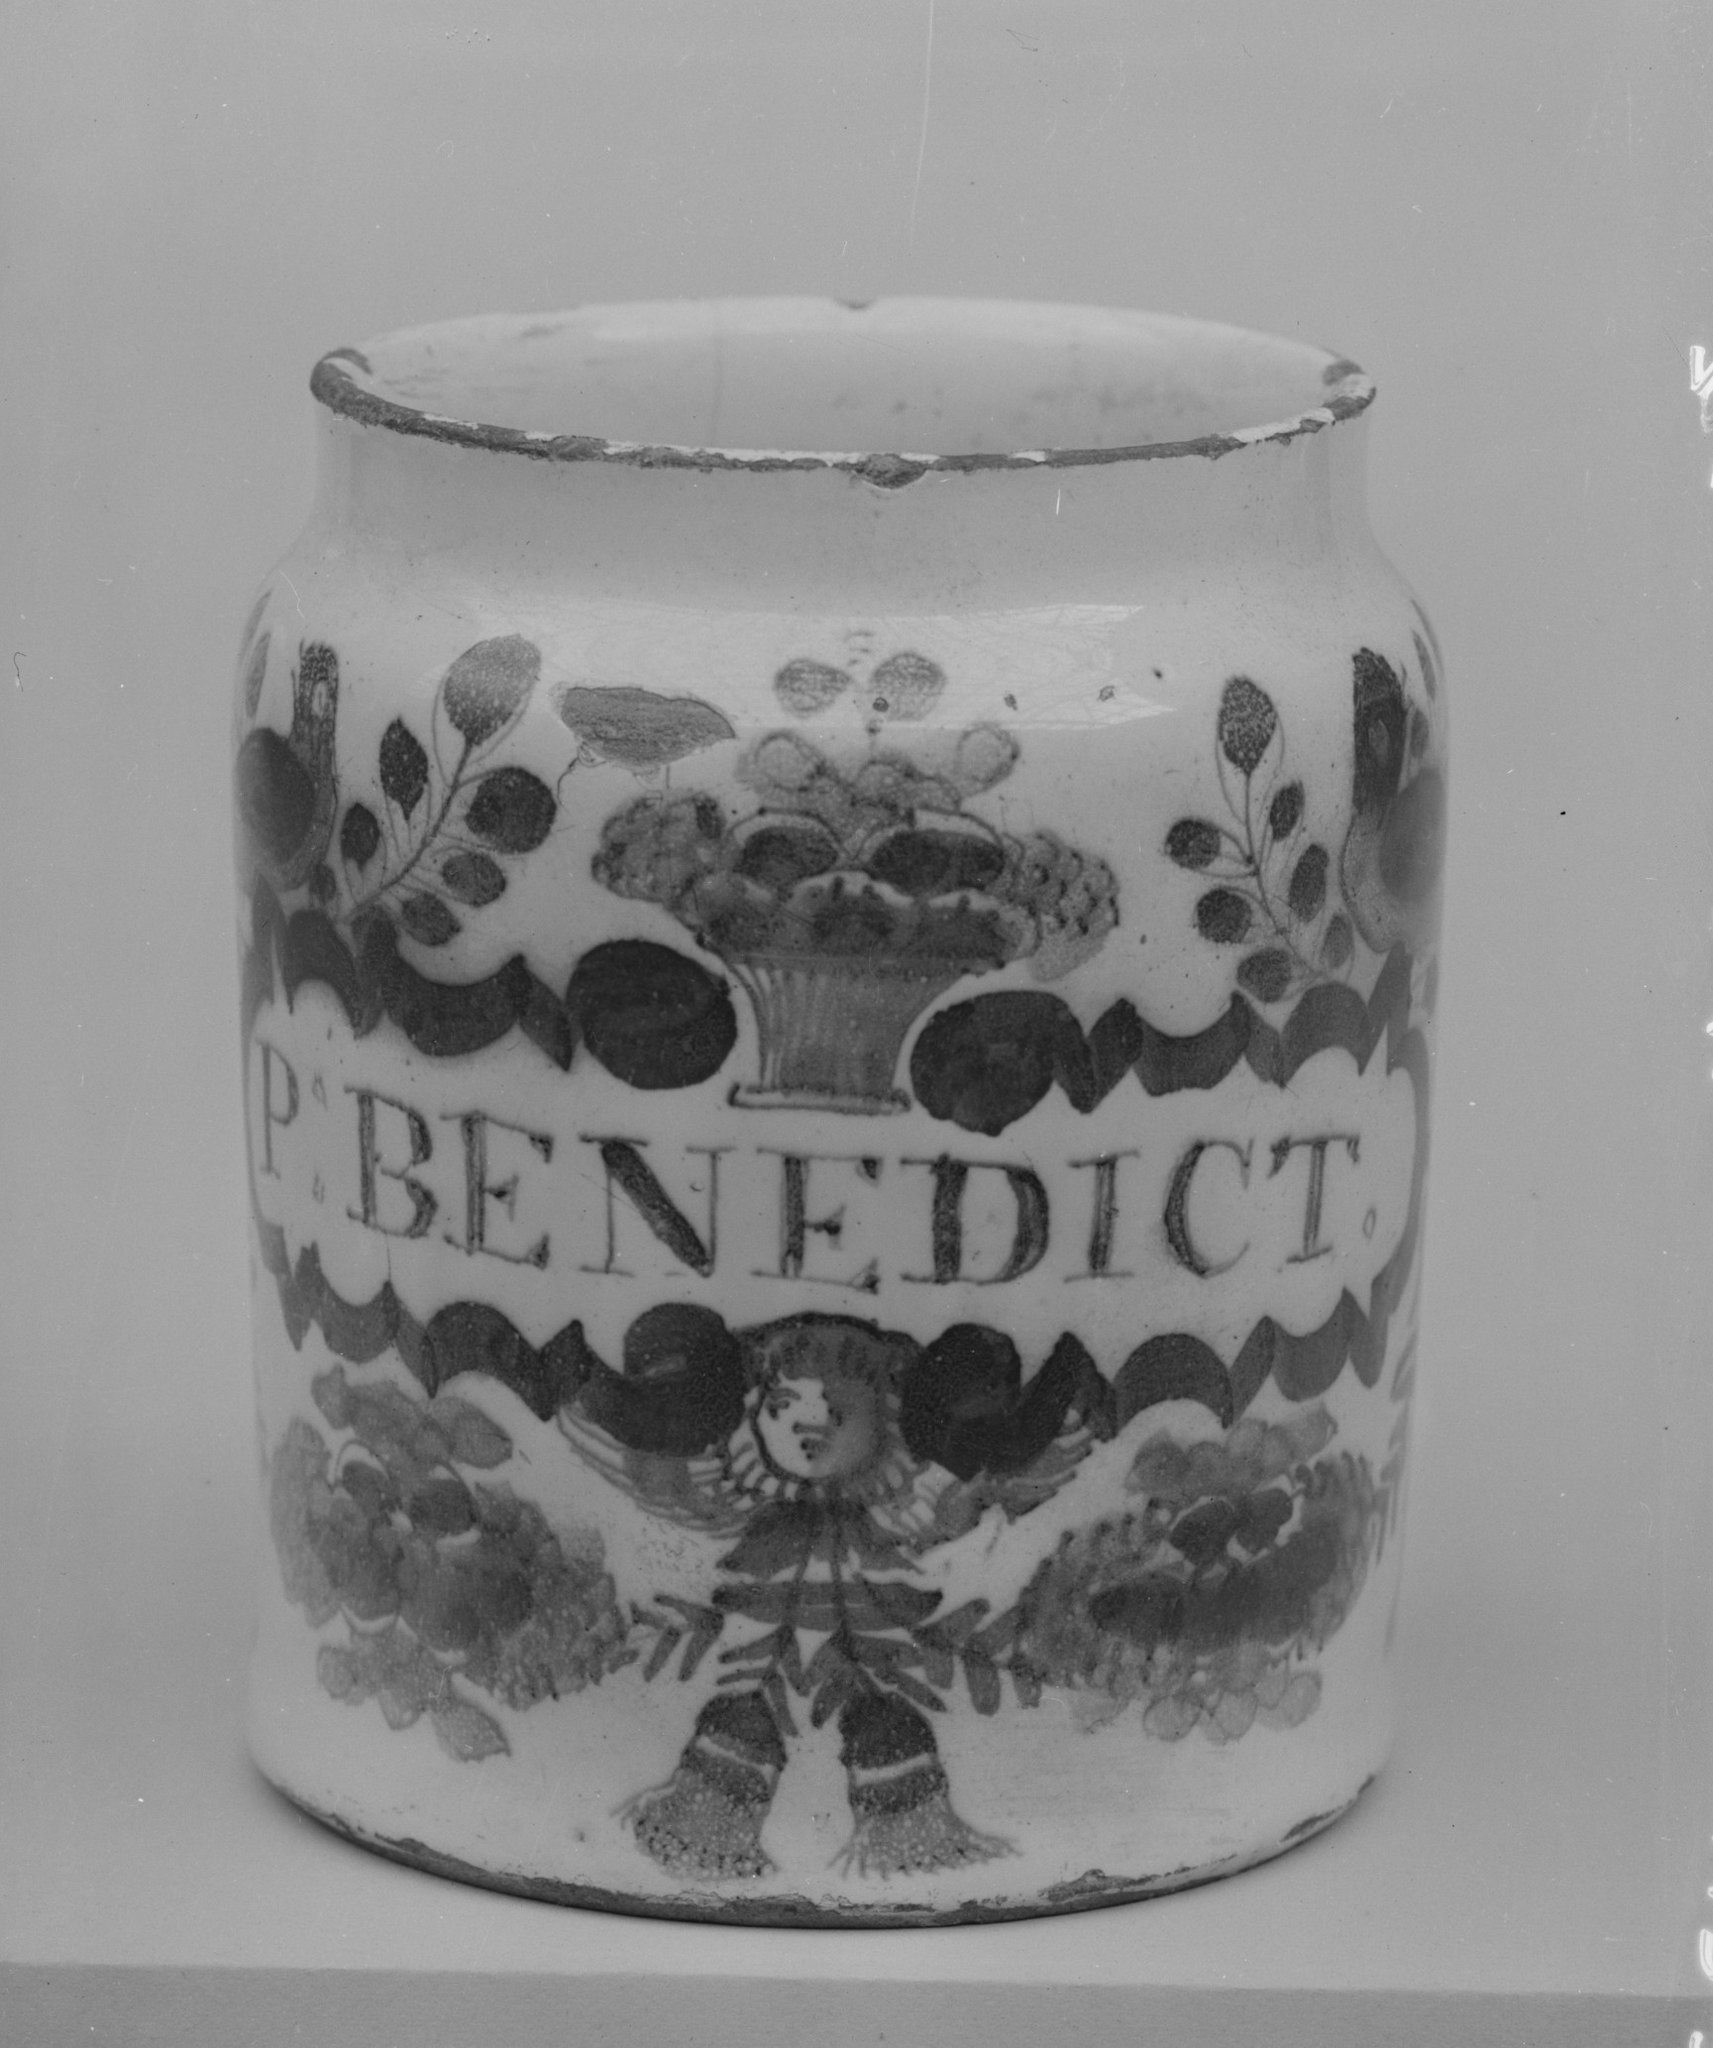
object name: apothecary jar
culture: dutch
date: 1730-1740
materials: earthenware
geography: netherlands